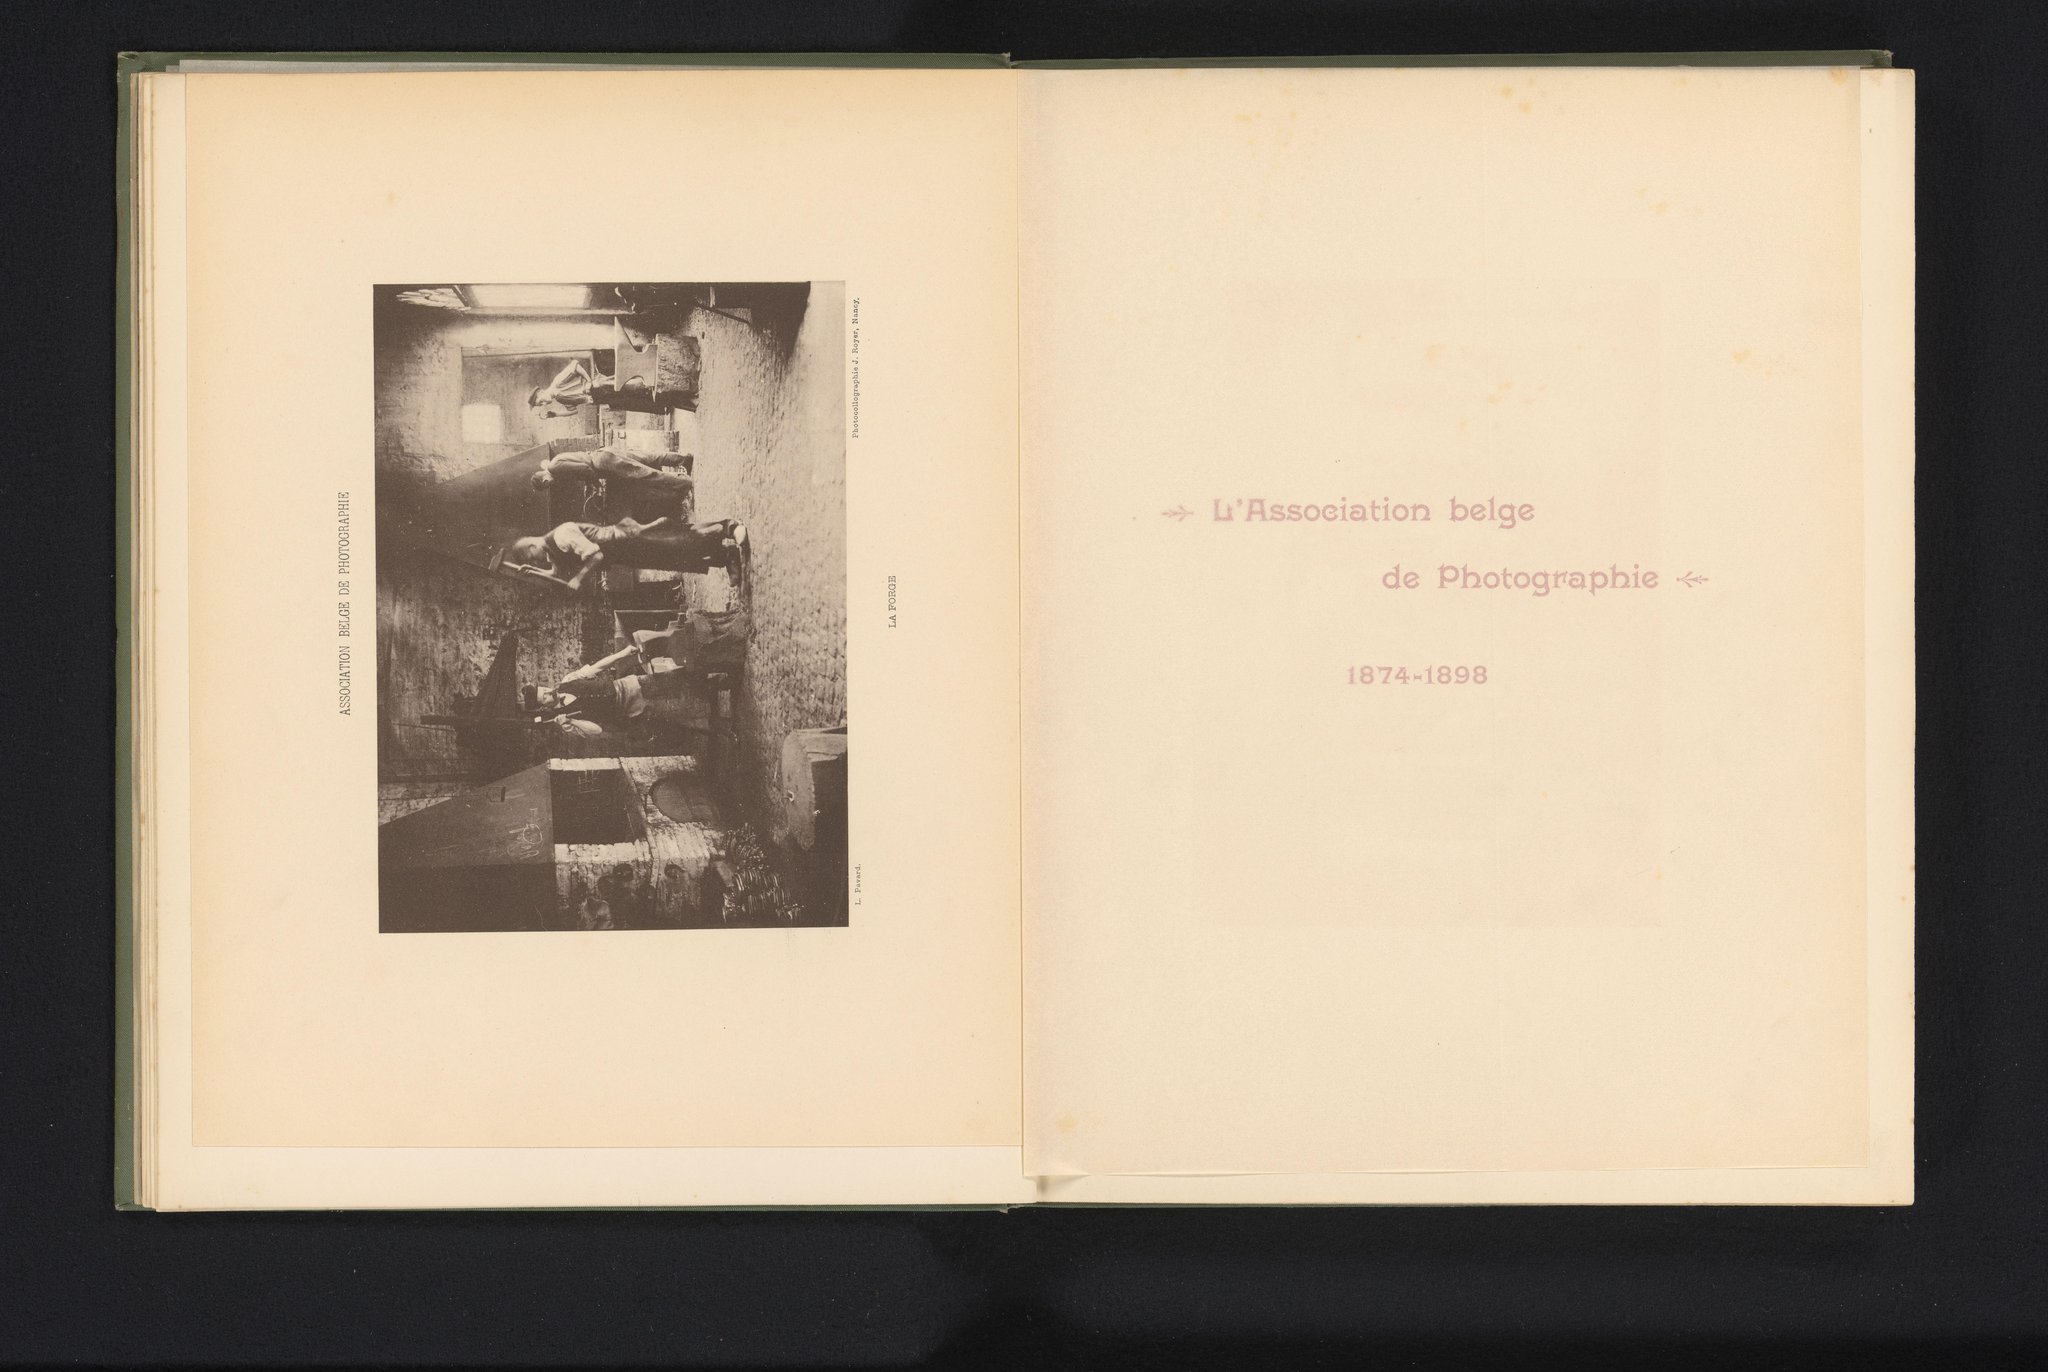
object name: page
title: La forge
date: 1893-1898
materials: paper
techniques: photograph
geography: nancy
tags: smith, blacksmith, forging (industrial process)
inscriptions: inscription: ‘Association Belge de photographie’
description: Prent op derde ongenummerde pagina na pagina 13.